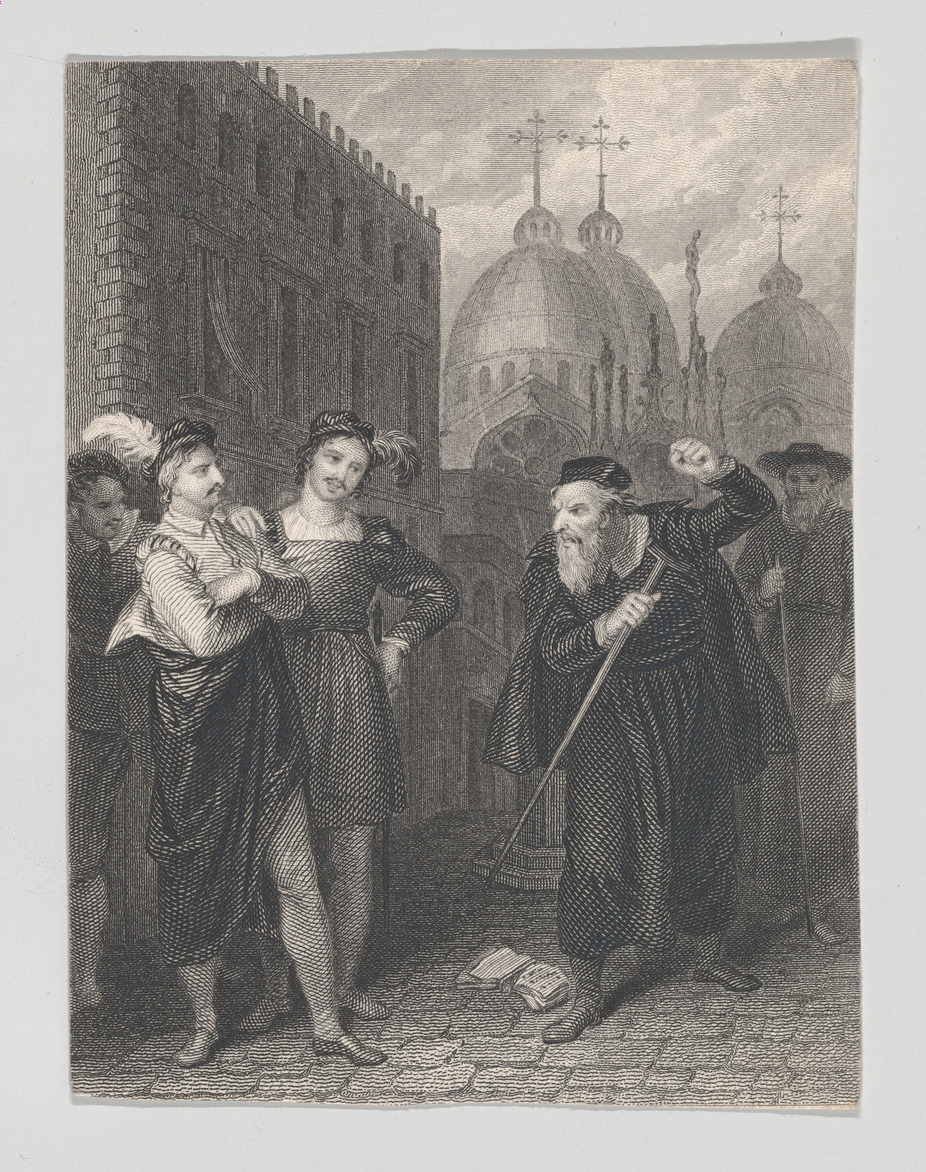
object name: print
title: Salanio, Salerio and Shylock (Shakespeare, Merchant of Venice, Act 3, Scene 1)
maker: john massey wright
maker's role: engraver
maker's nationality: british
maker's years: 1777-1866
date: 1825-1840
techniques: engraving, etching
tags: theatre,shakespeare,men